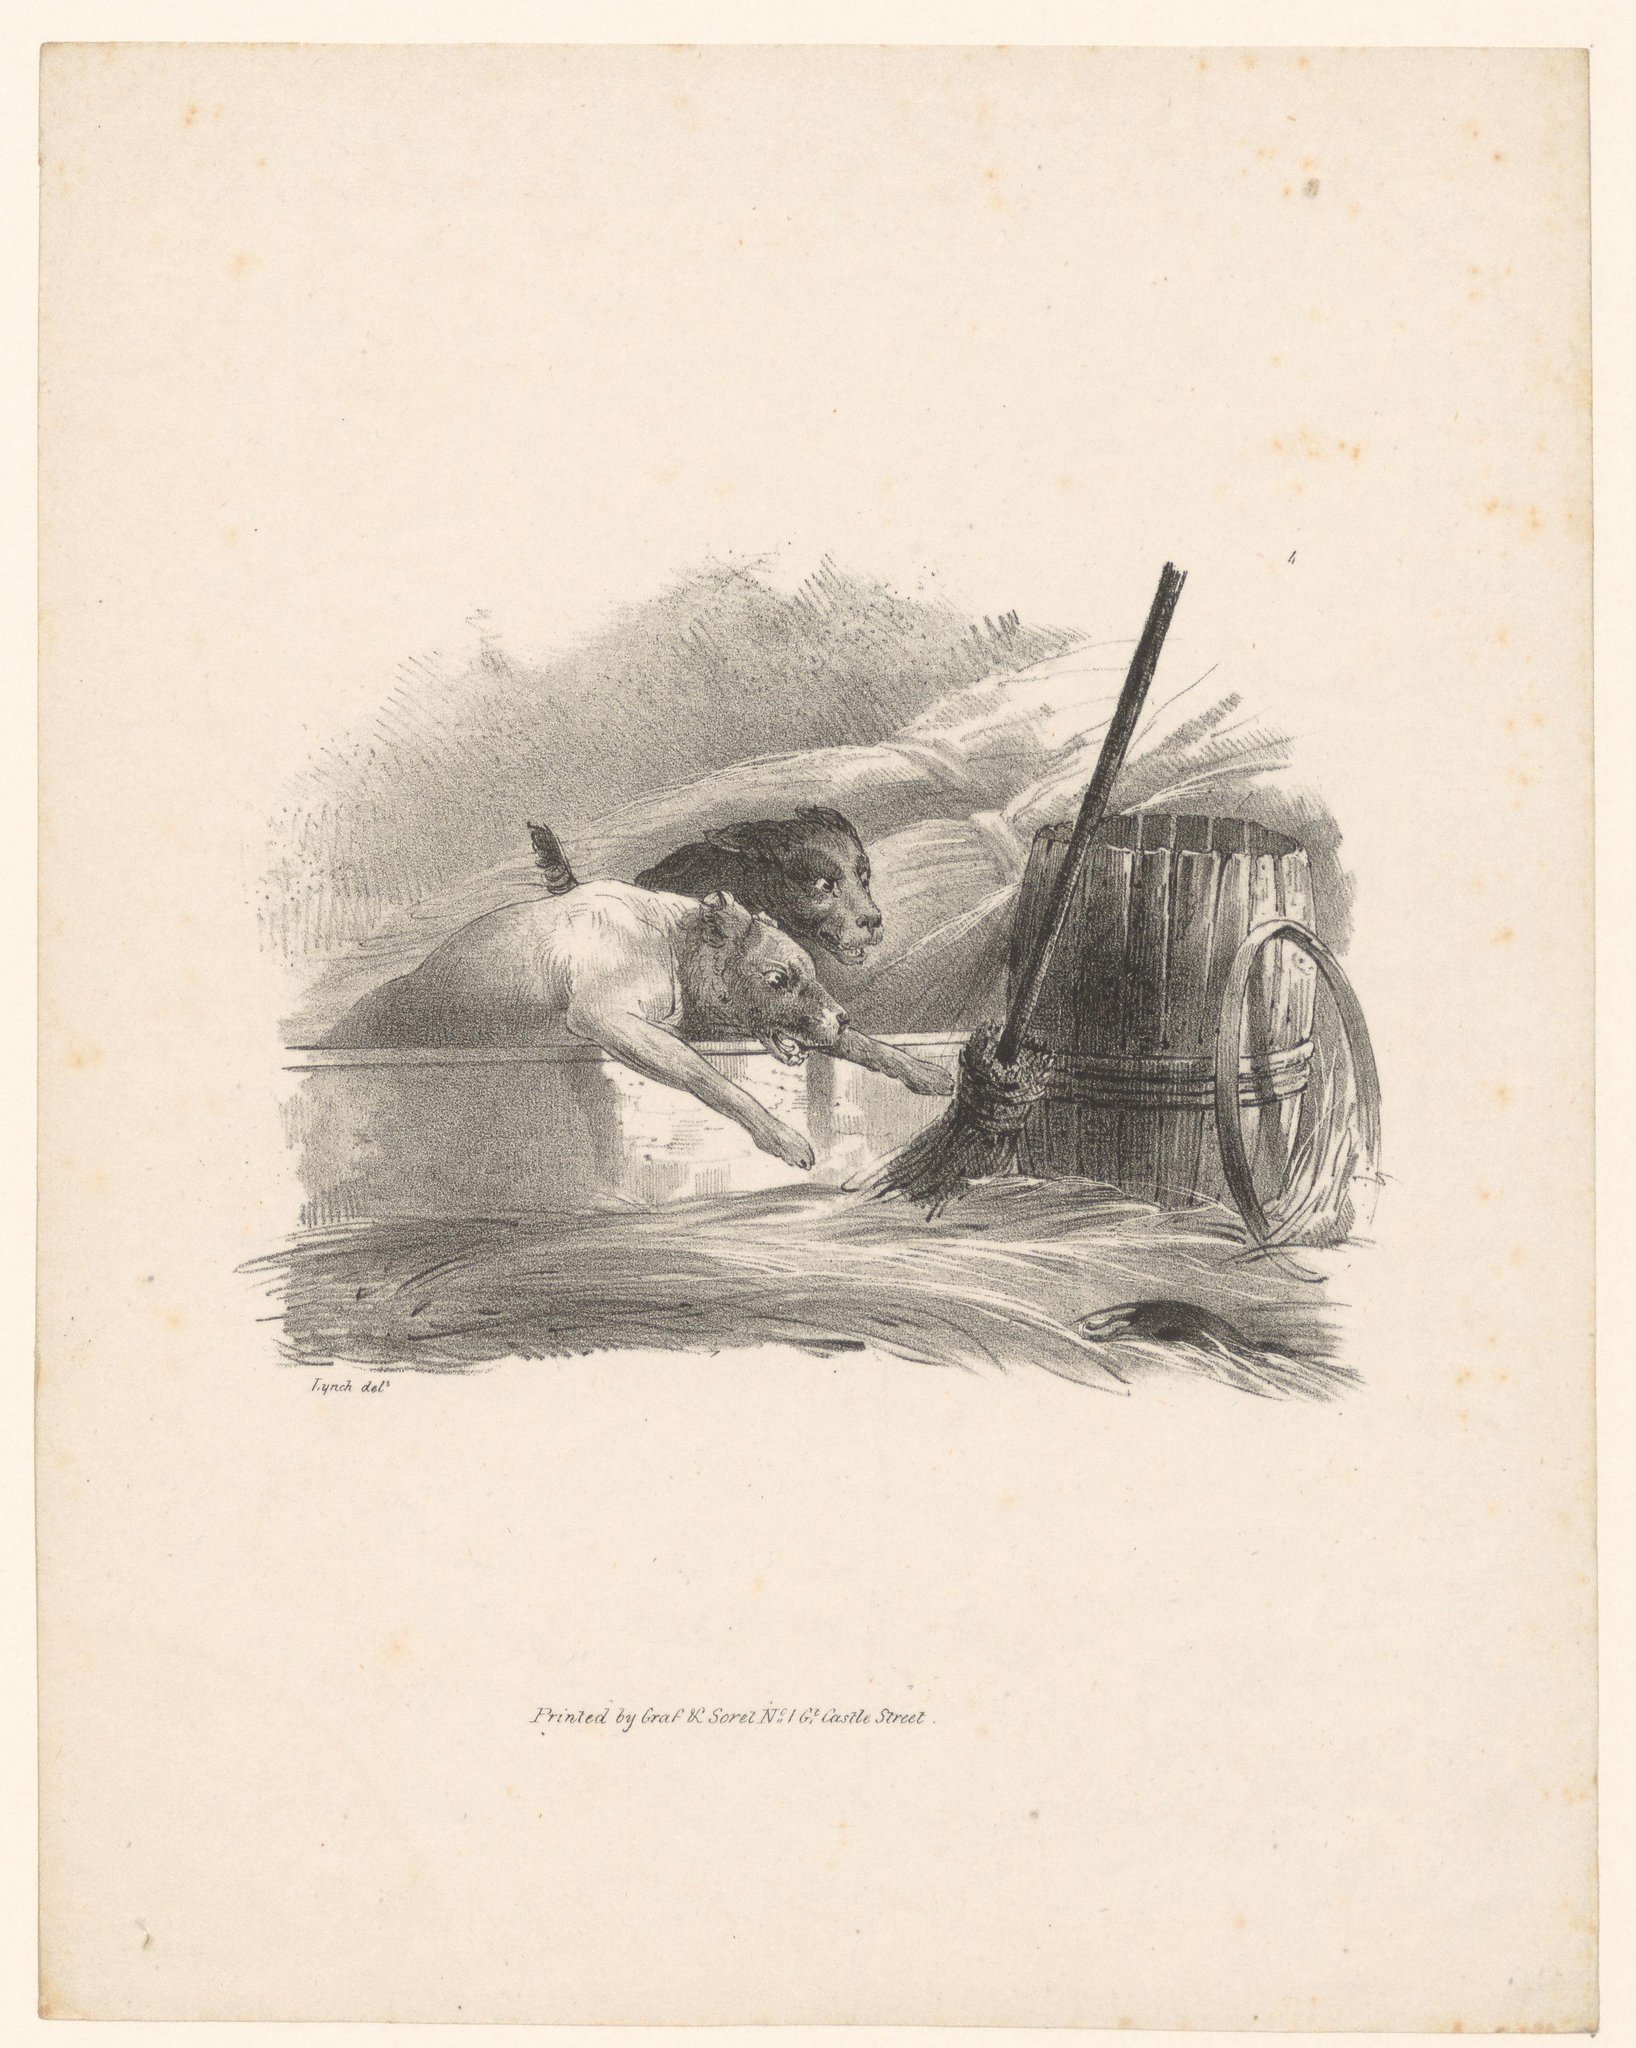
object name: print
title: Twee honden jagen op een muis in het hooi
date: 1830-1838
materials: paper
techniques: lithograph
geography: london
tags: agricultural products and by-products: hay, rodents: mouse, dog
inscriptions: collector's mark: Lugt 2233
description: Prent maakt waarschijnlijk deel uit van een serie met diervoorstellingen. Over deze serie is verder niets bekend. Het betreft voornamelijk voorstellingen van honden.